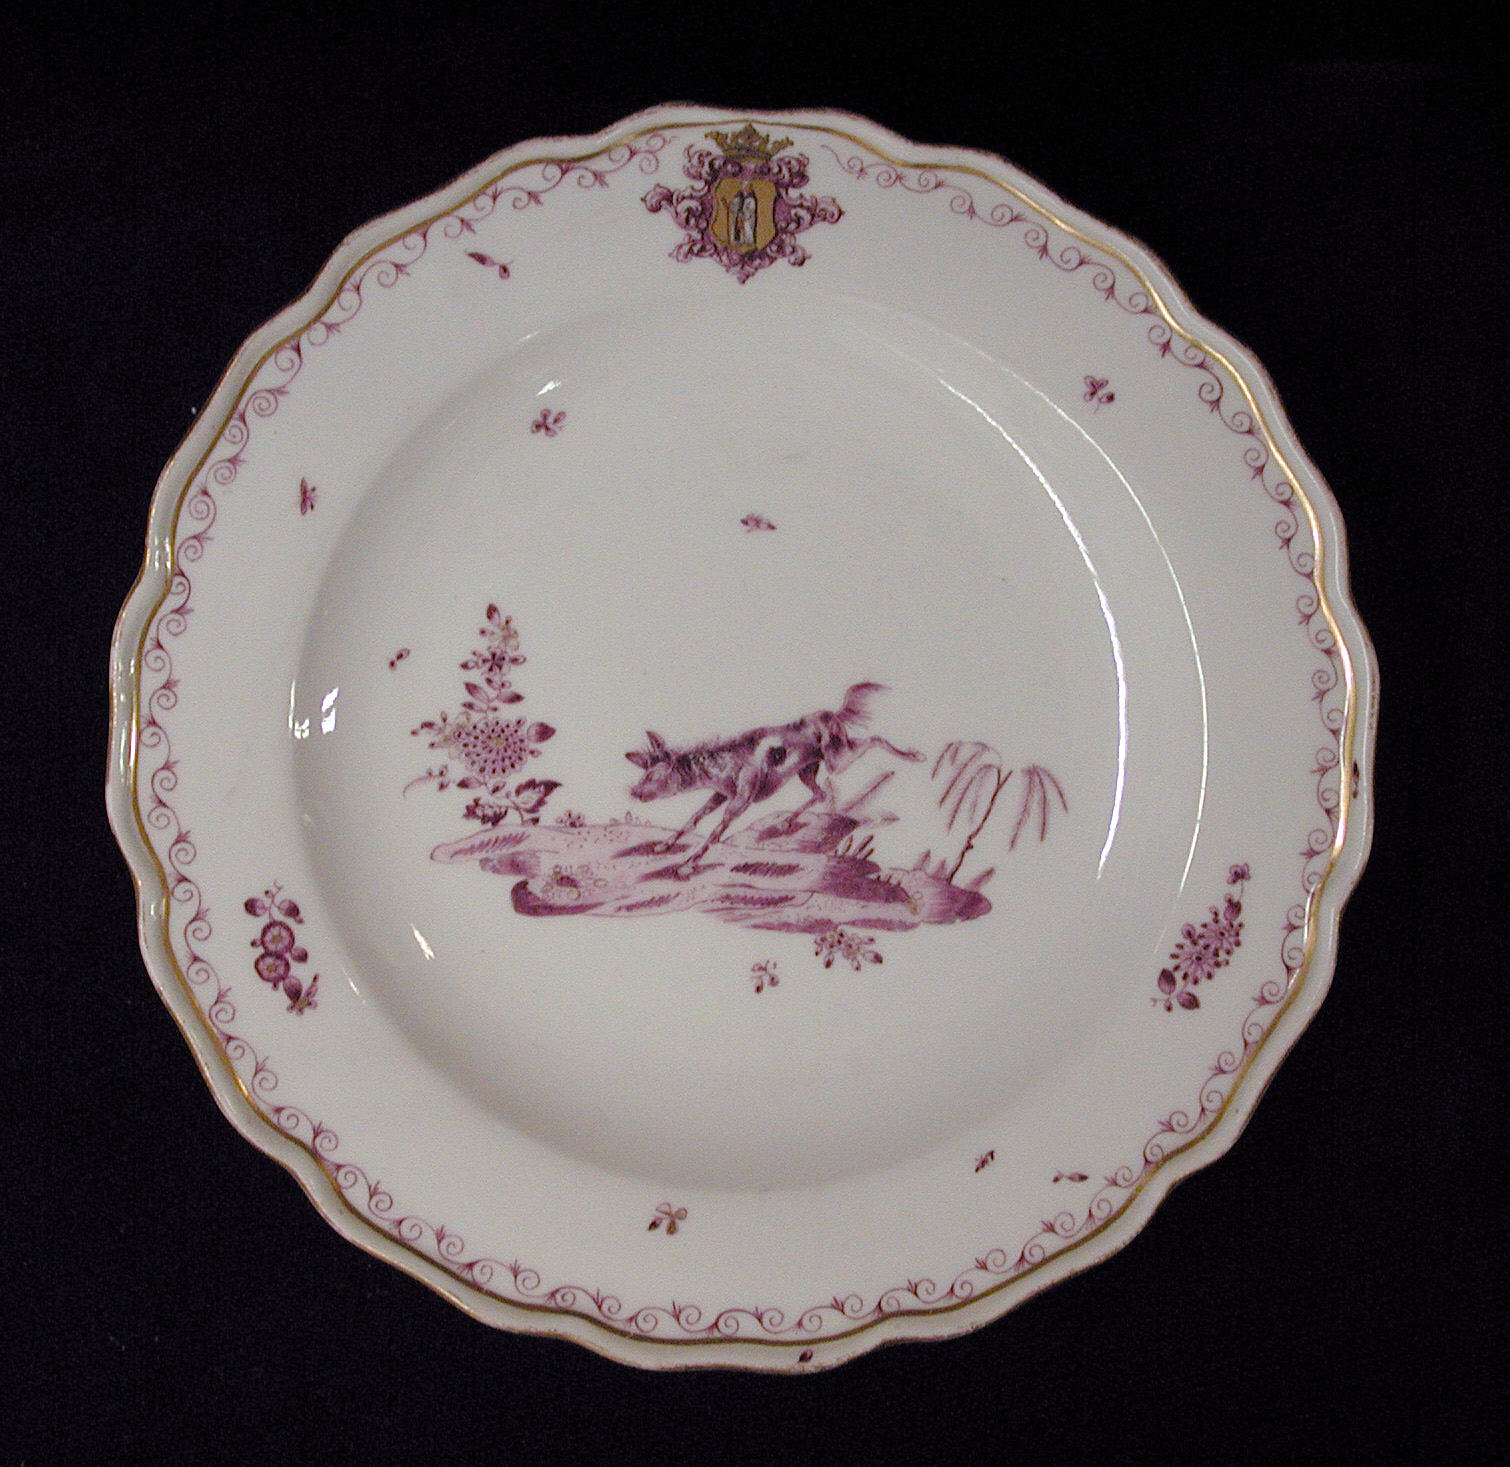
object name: plate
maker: meissen manufactory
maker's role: manufactory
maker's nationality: german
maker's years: 1710-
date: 1745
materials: hard paste porcelain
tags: dogs,flowers,plants,coat of arms